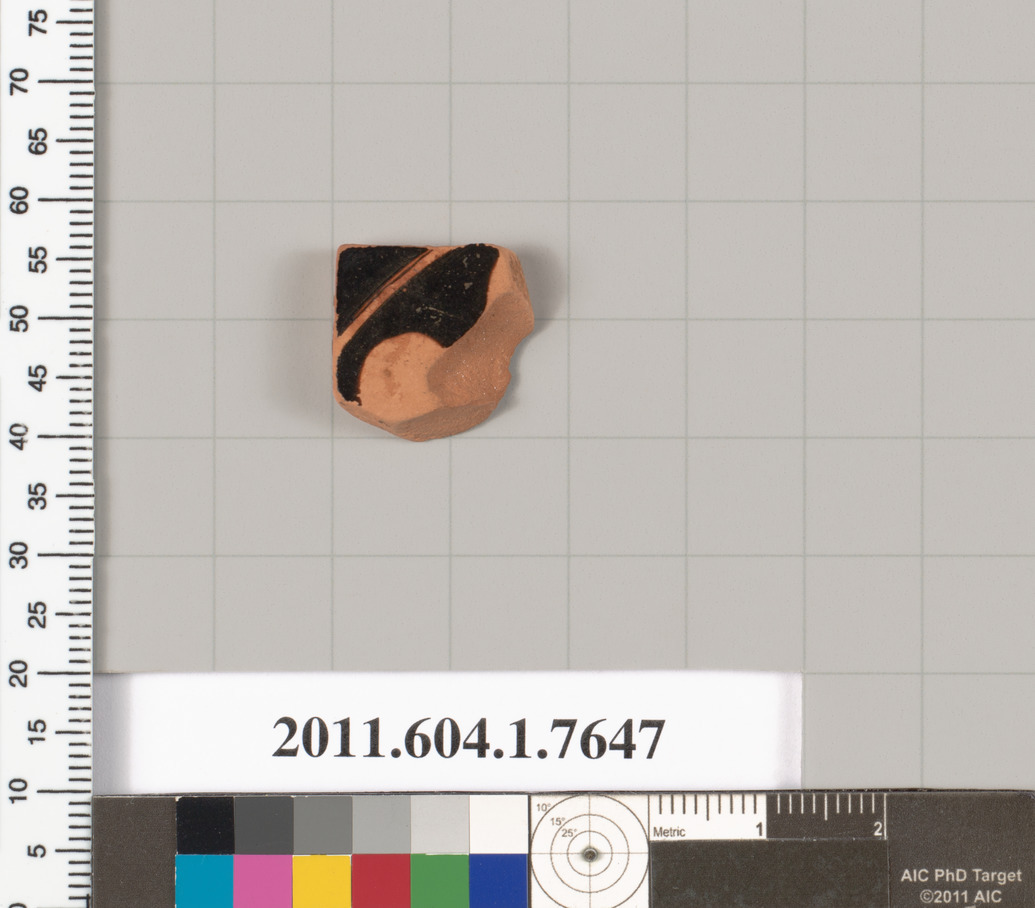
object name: kylix fragment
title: Terracotta fragment of a kylix (drinking cup)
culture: greek, attic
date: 460-450 BCE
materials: terracotta